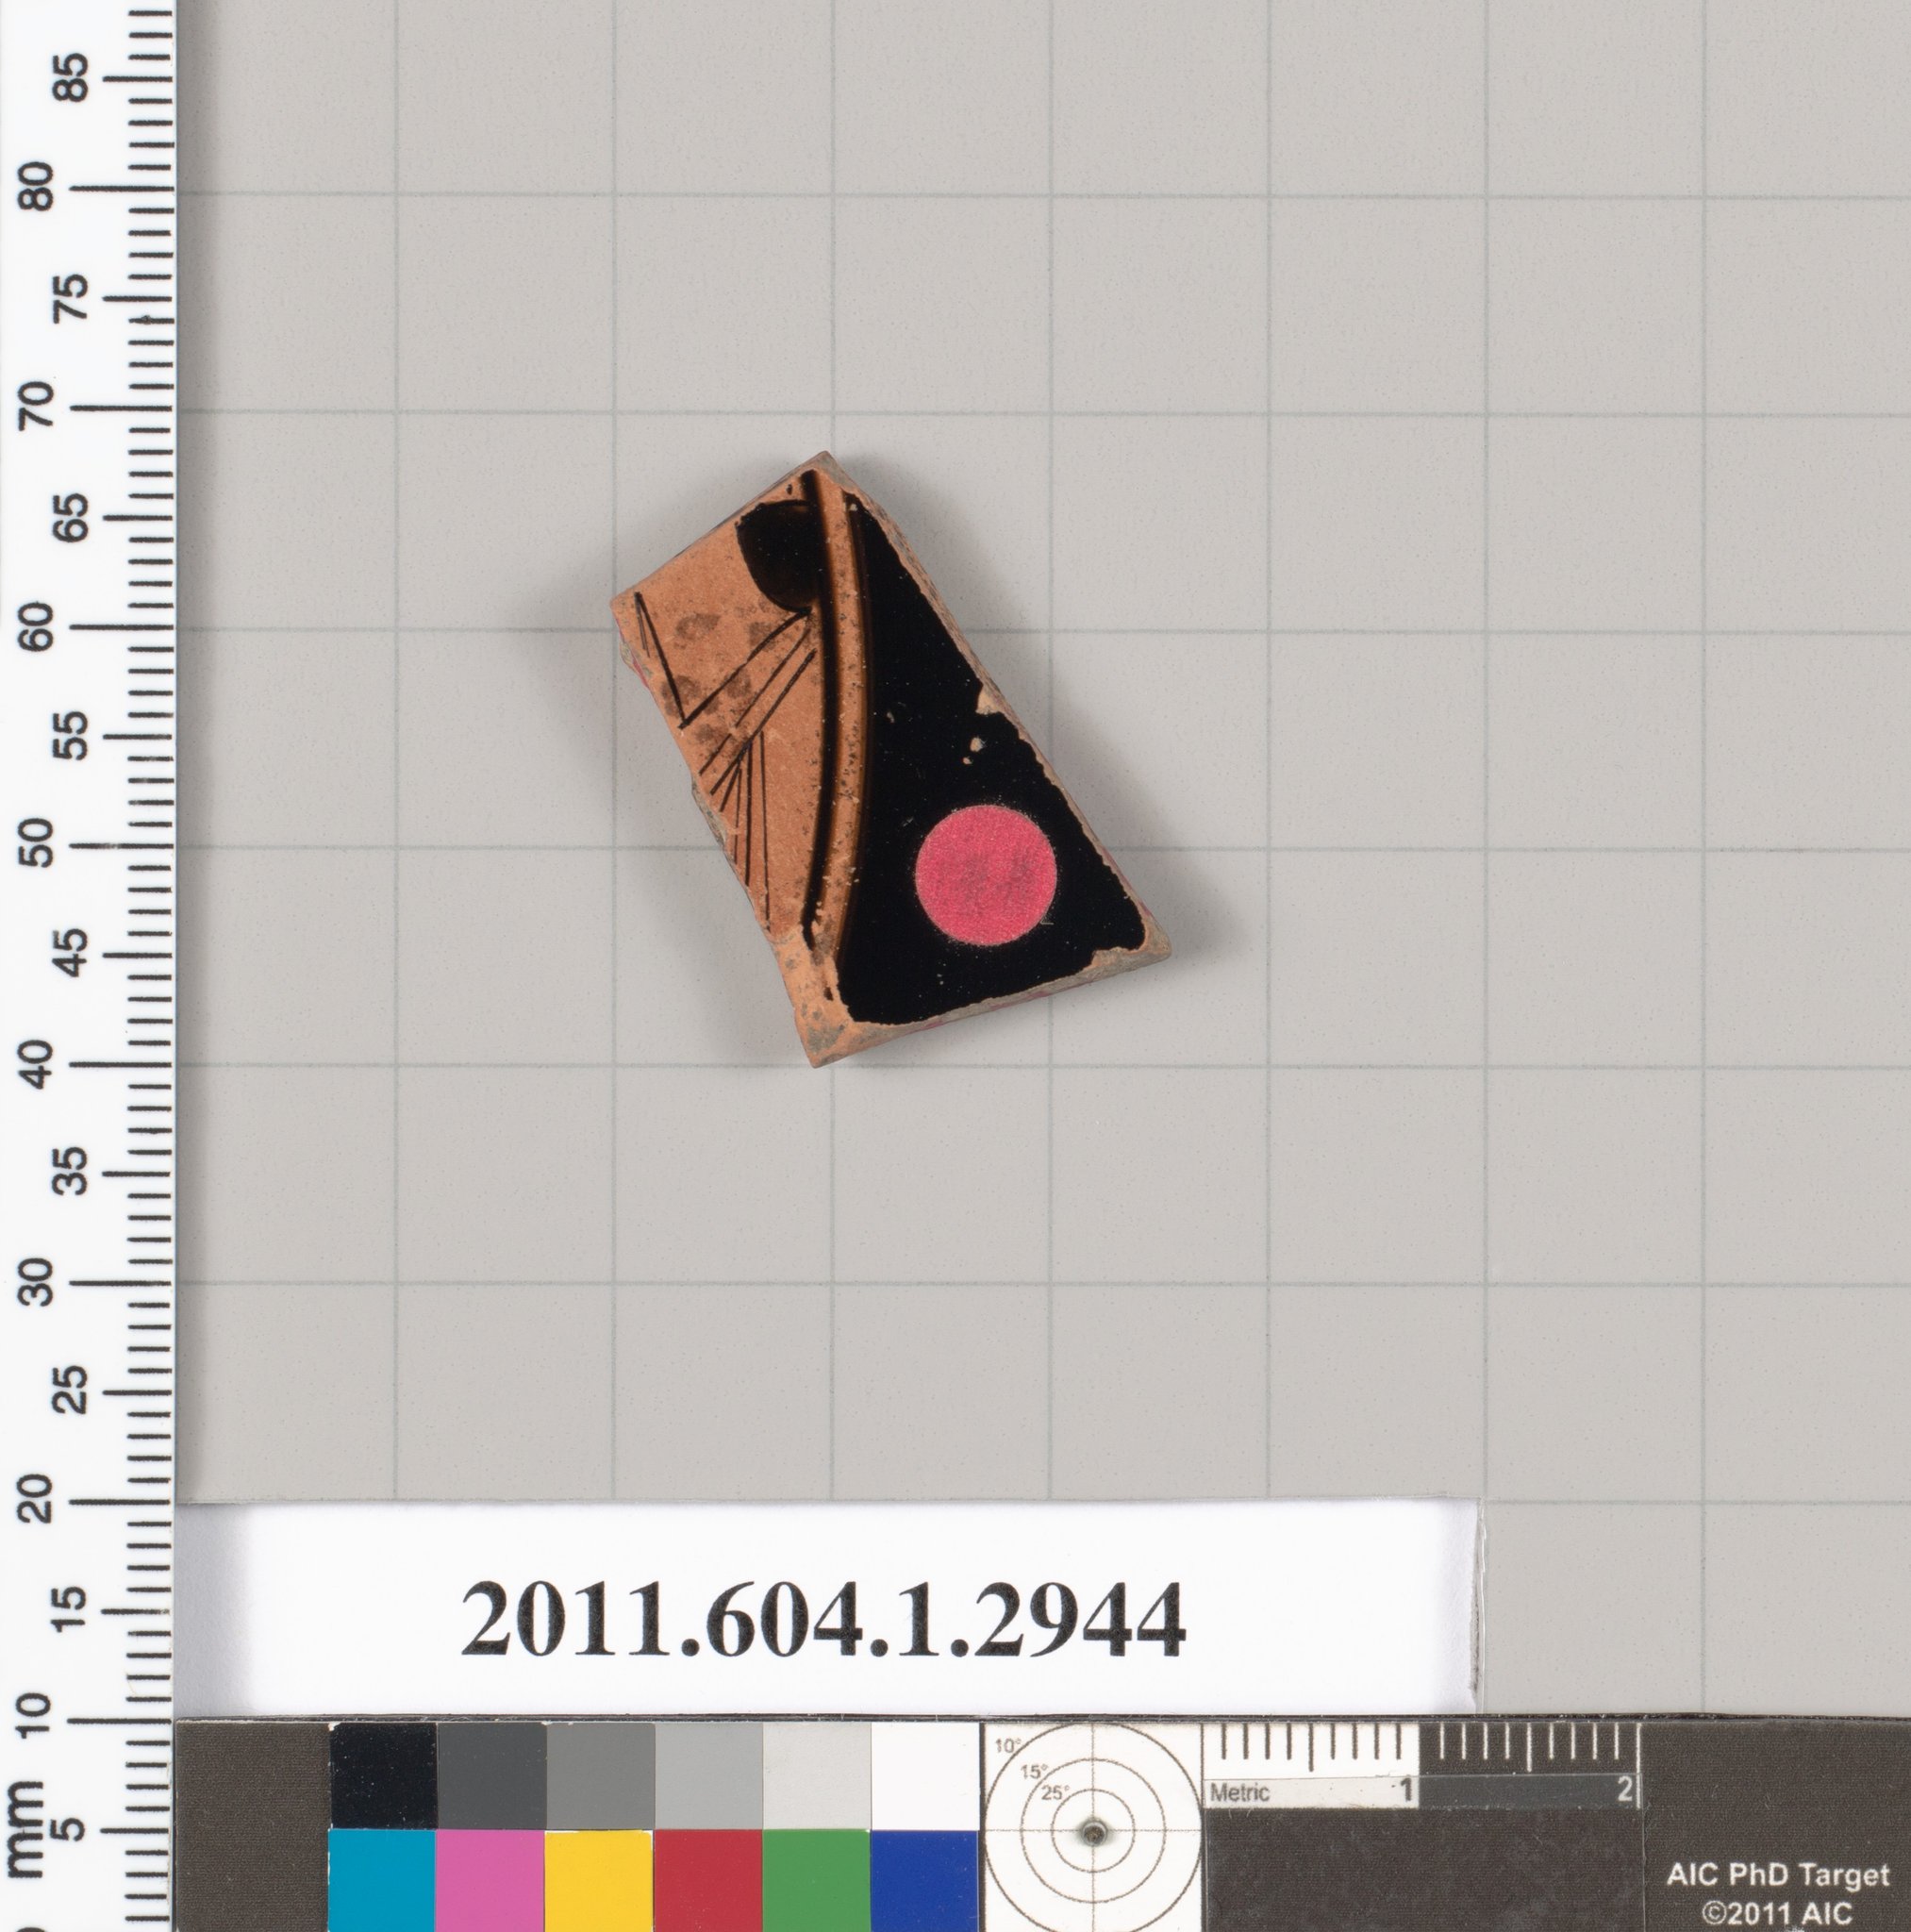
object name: kylix fragment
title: Terracotta fragment of a kylix (drinking cup)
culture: greek, attic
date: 500-490 BCE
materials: terracotta